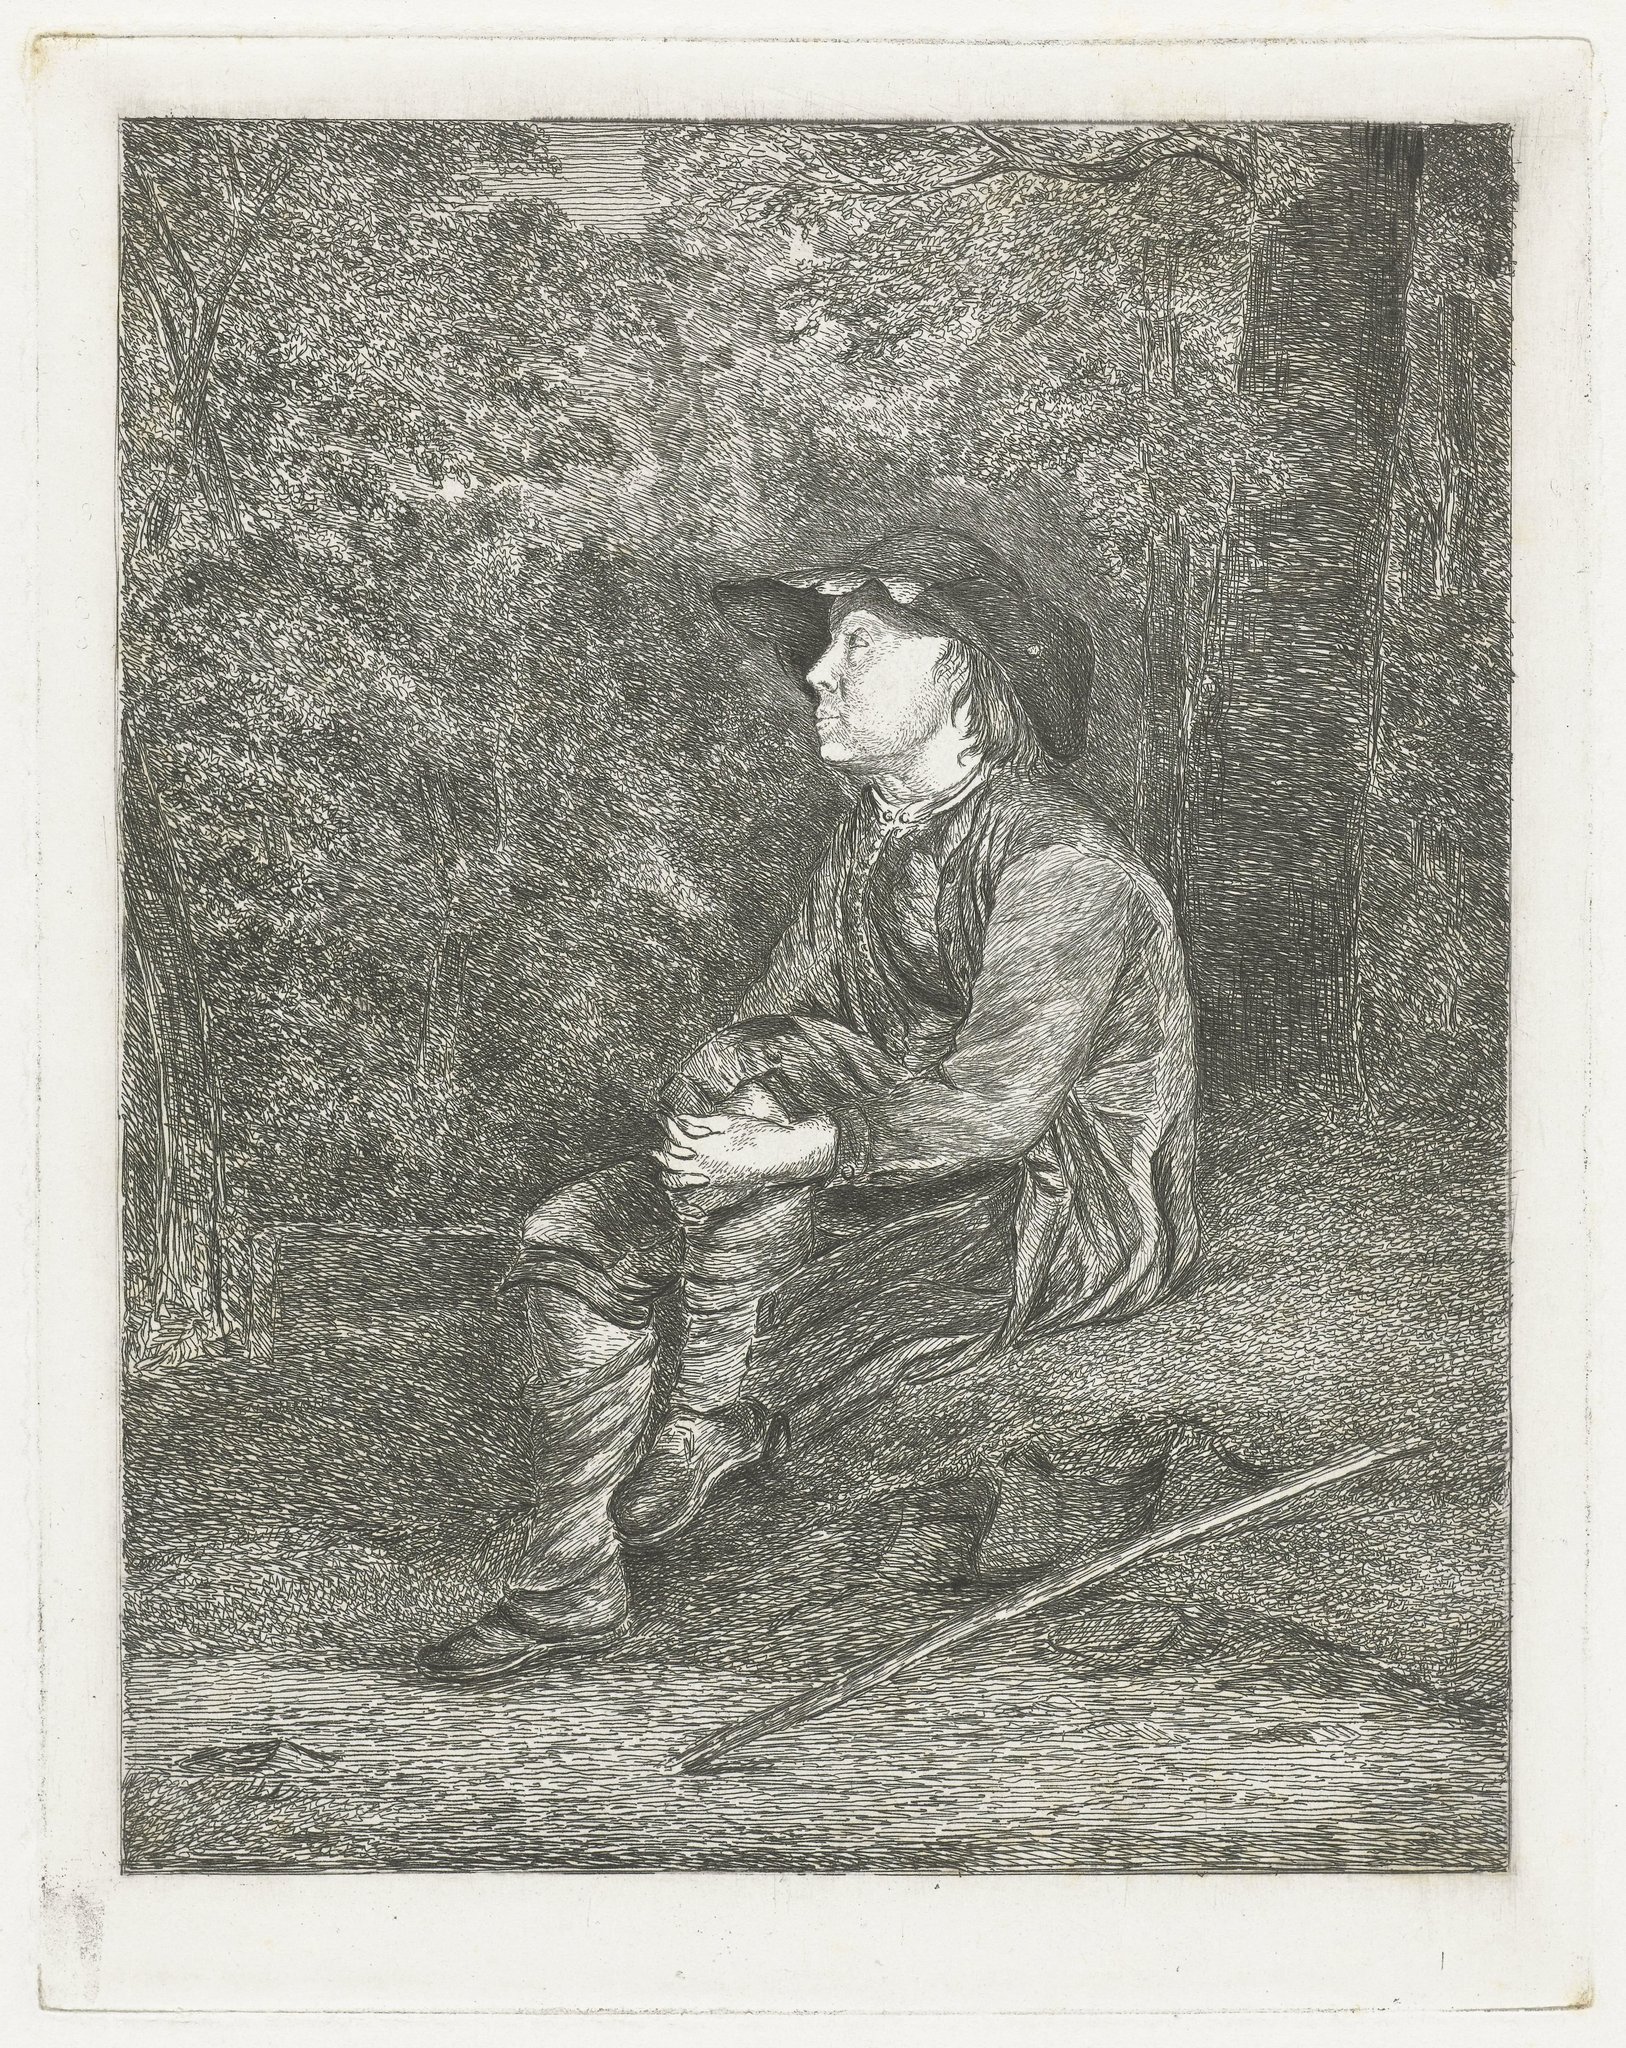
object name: print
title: Zittend jongetje in het bos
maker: jacobus cornelis gaal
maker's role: print maker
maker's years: 1796-1866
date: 1854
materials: paper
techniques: etching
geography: netherlands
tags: forest, wood (+ landscape with figures, staffage)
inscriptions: collector's mark: Lugt 2228